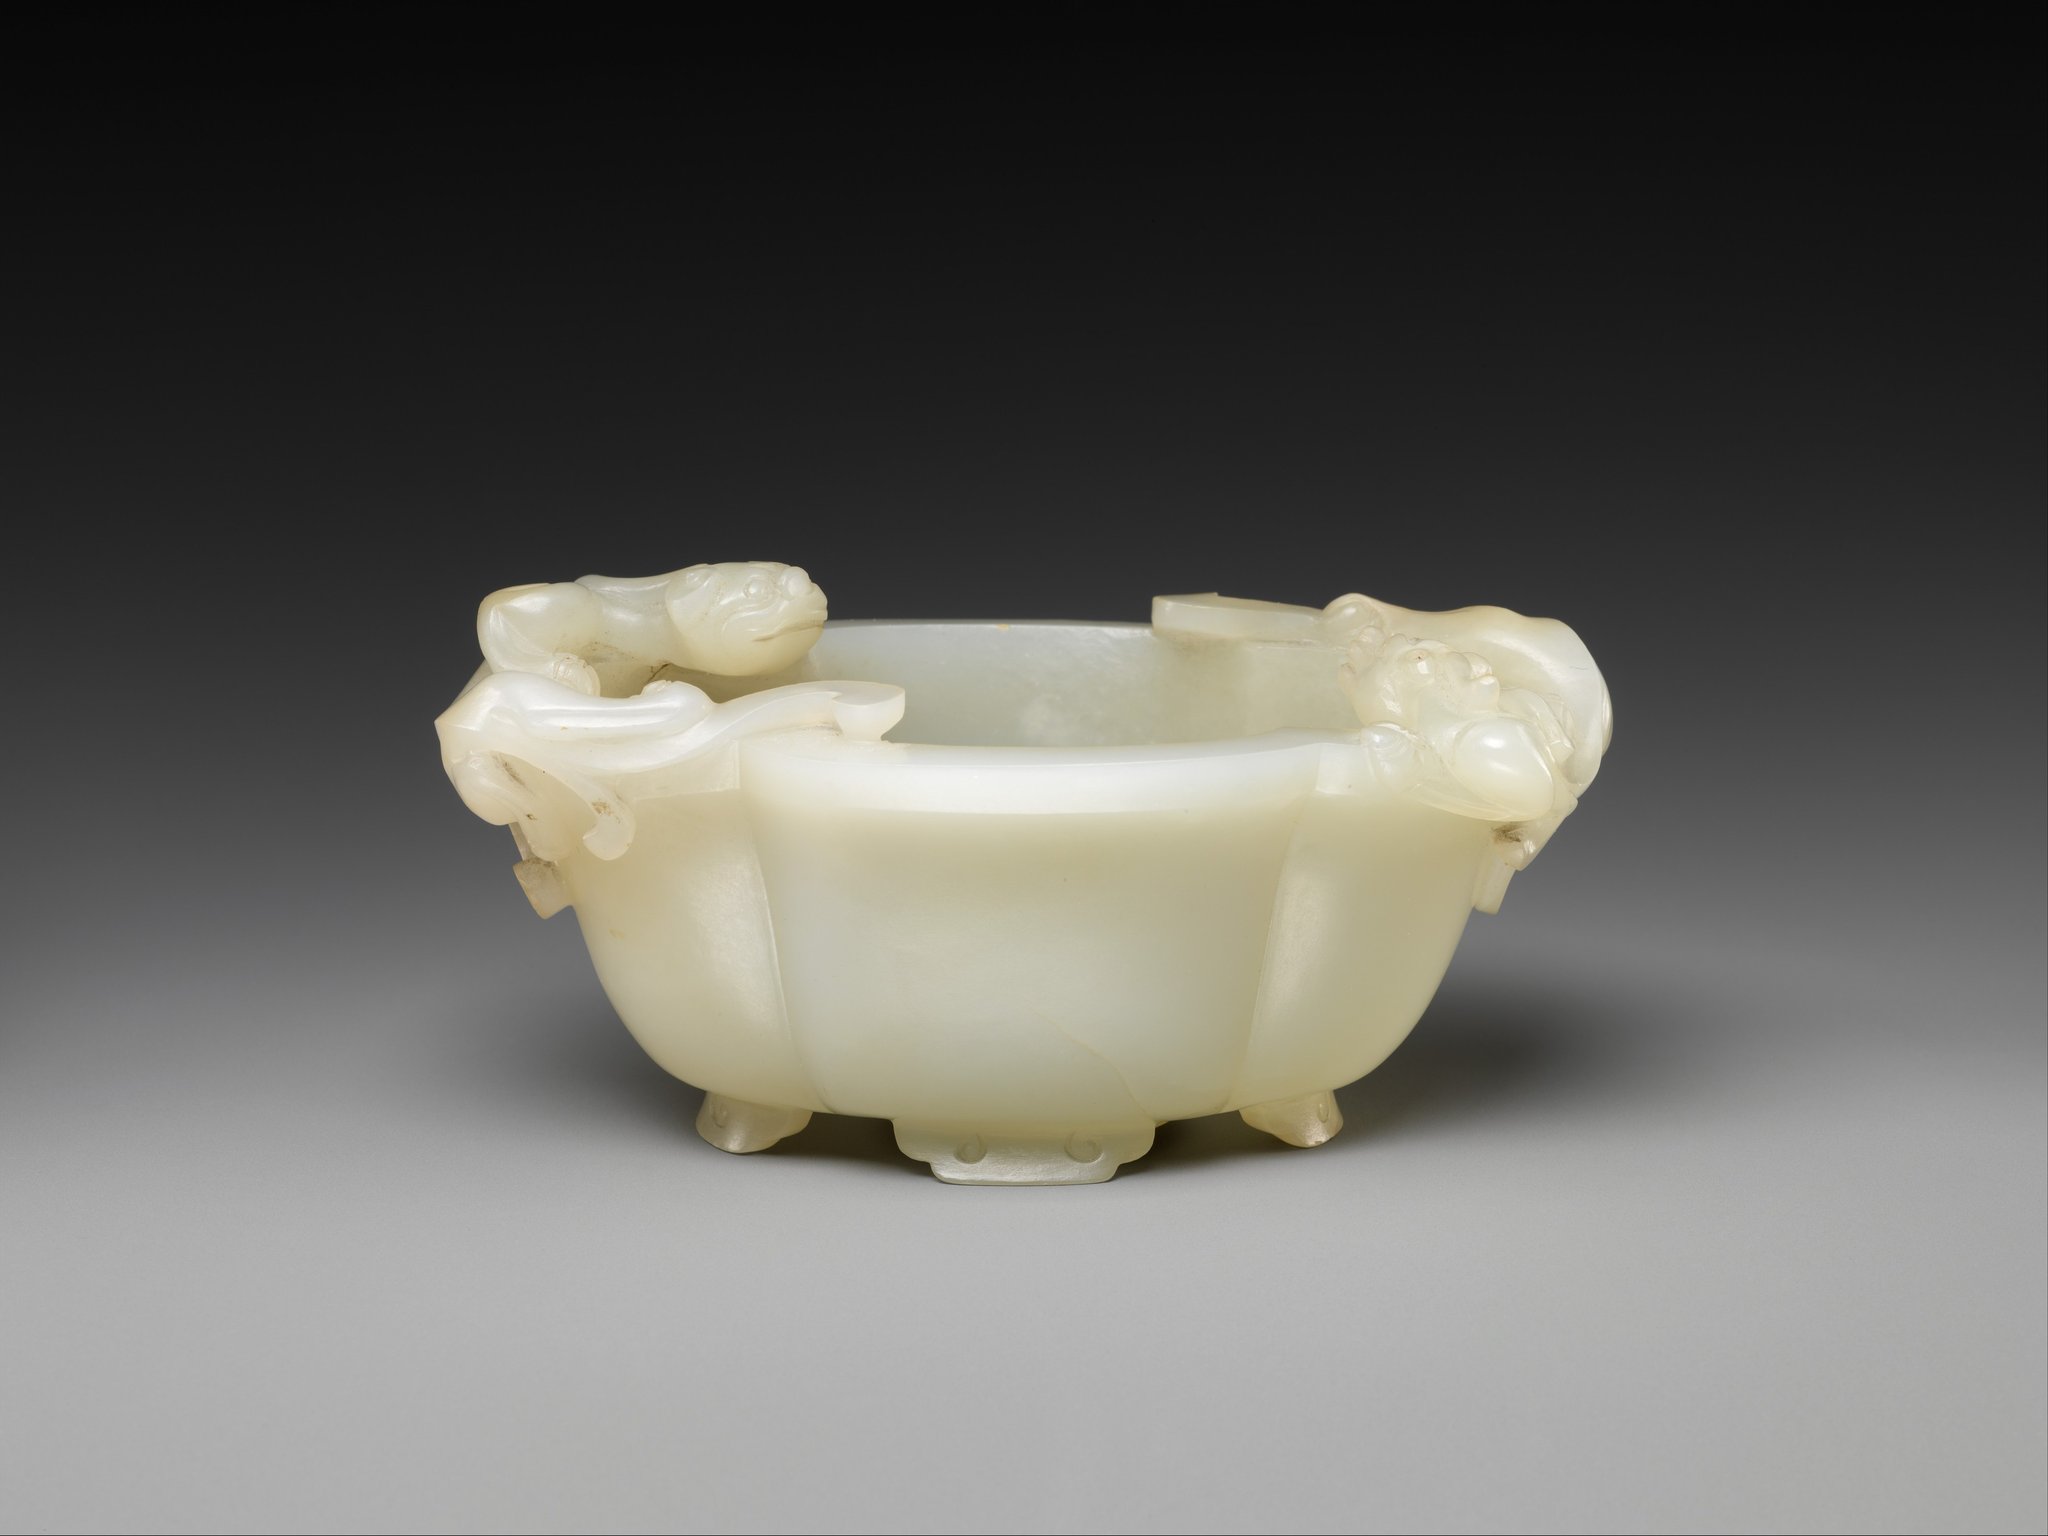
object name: cup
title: Cup with two feline dragons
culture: chinese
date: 1701-1800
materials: jade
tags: dragons